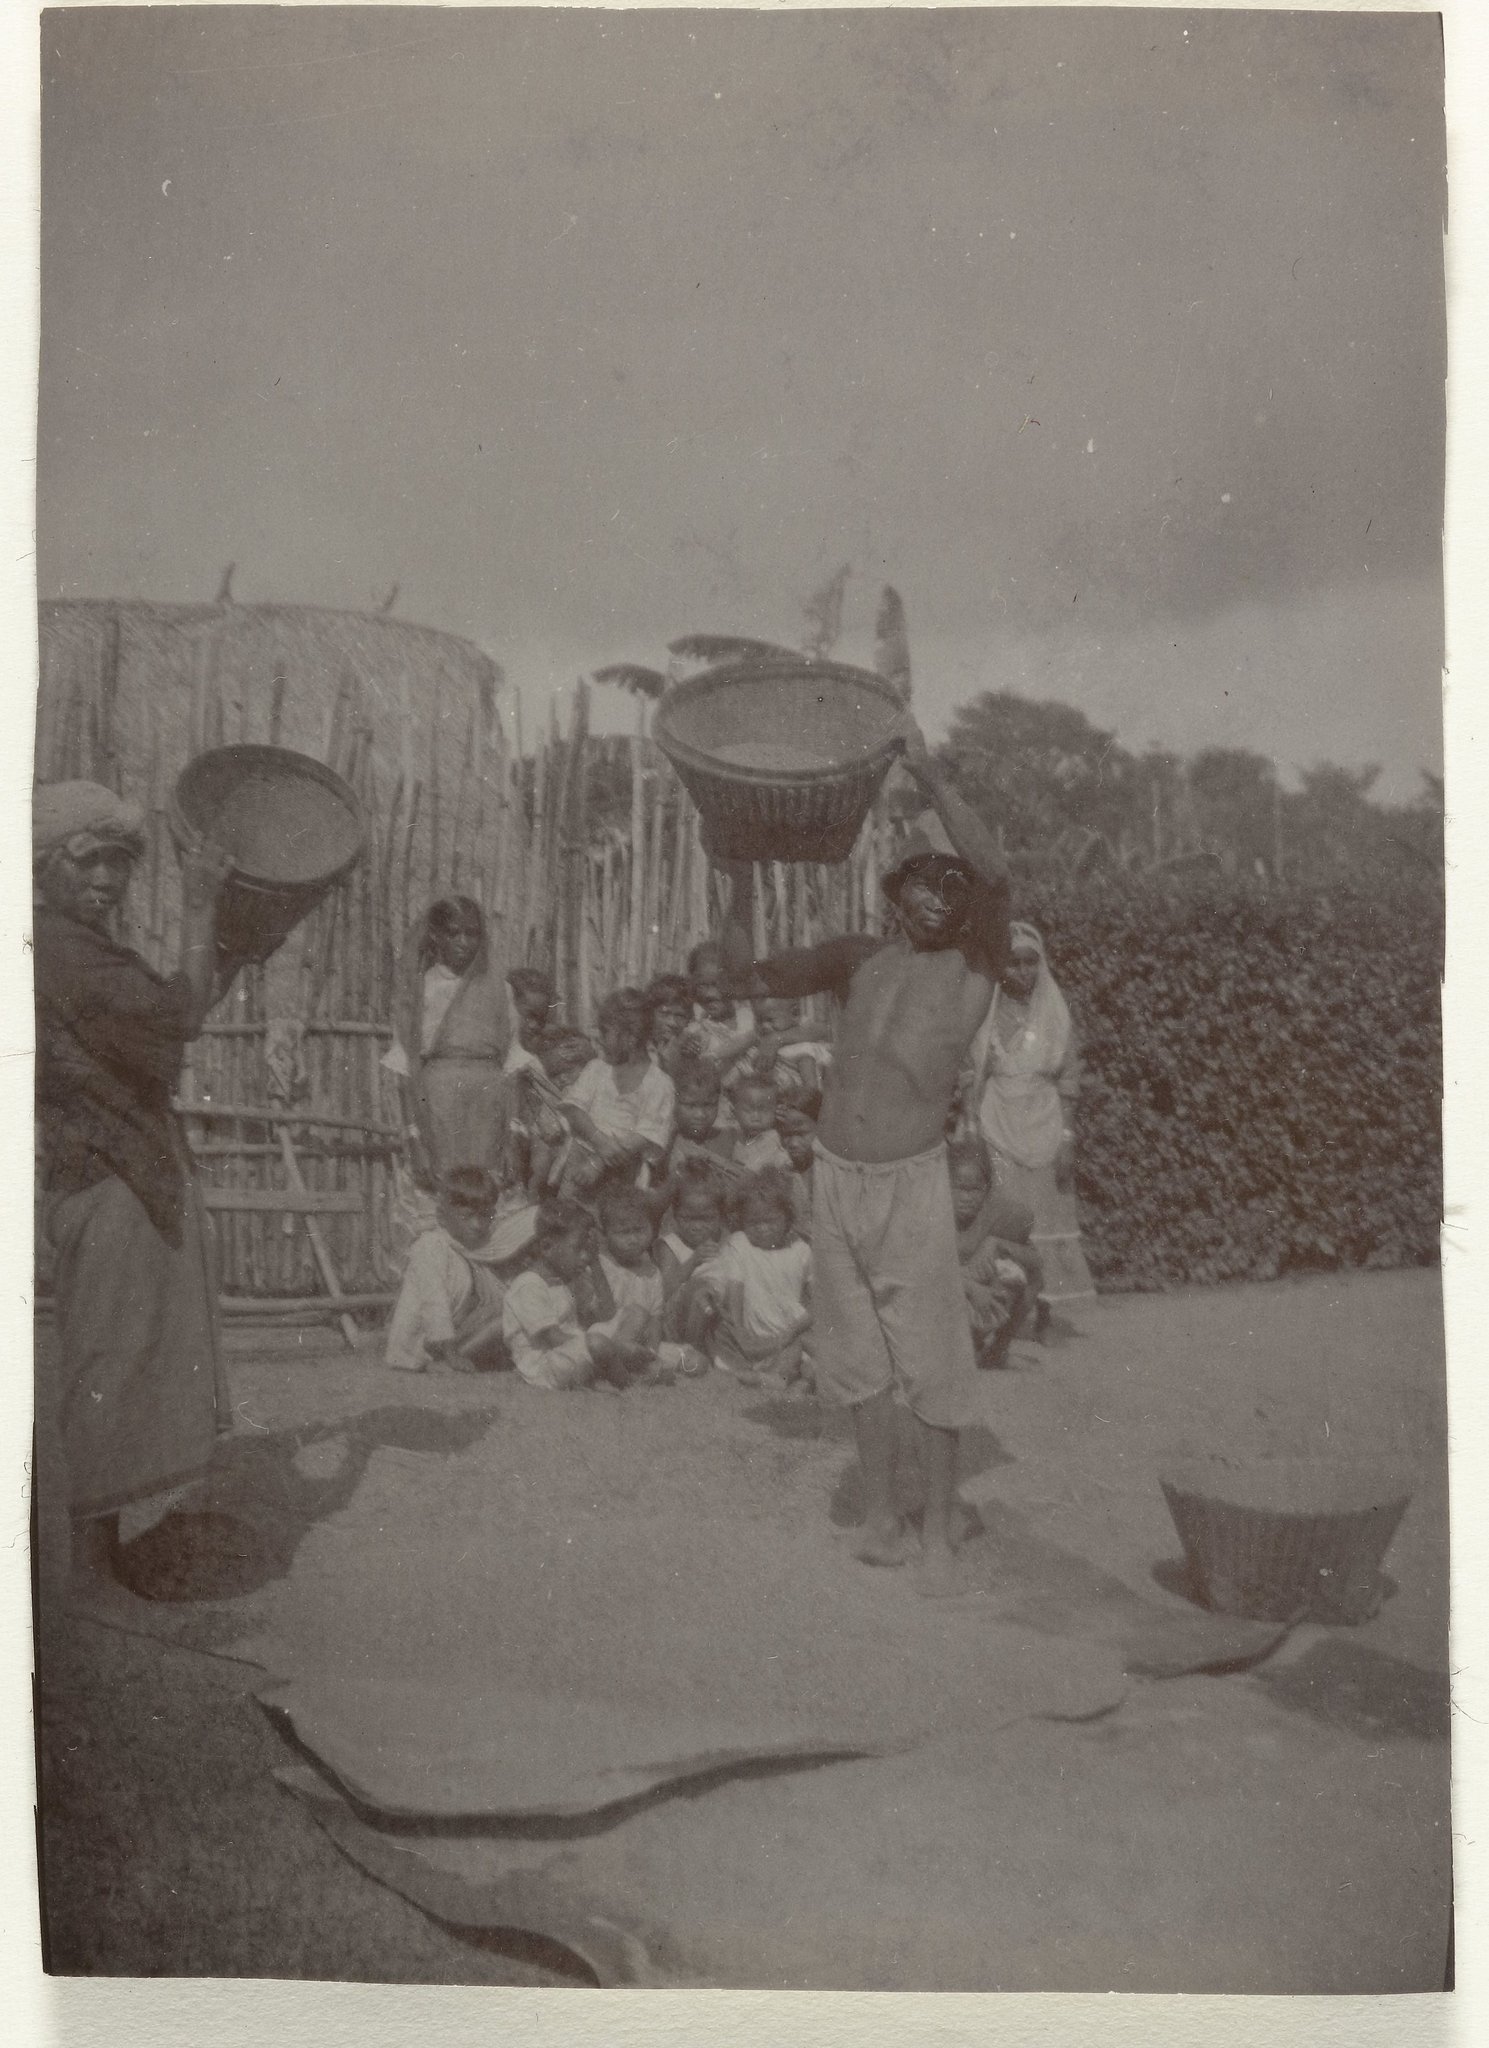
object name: photograph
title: Hindustani and Javanese Indentured Labourers at the Accaribo Plantation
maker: theodoor brouwers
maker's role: amateurfotograaf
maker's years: 1874-1932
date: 1916-1930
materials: photographic support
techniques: photography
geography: suriname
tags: amsterdam, theodoor brouwers, plantation, suriname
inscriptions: inscription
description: Both Javanese and Hindustani contract labourers work on the Accaribo Plantation. Their homes are located on the edge of the plantation. They often develop close ties and exchange cultural traditions. While their parents work, the two young Hindustani girls look after the little ones, assuming great responsibility at an early age.